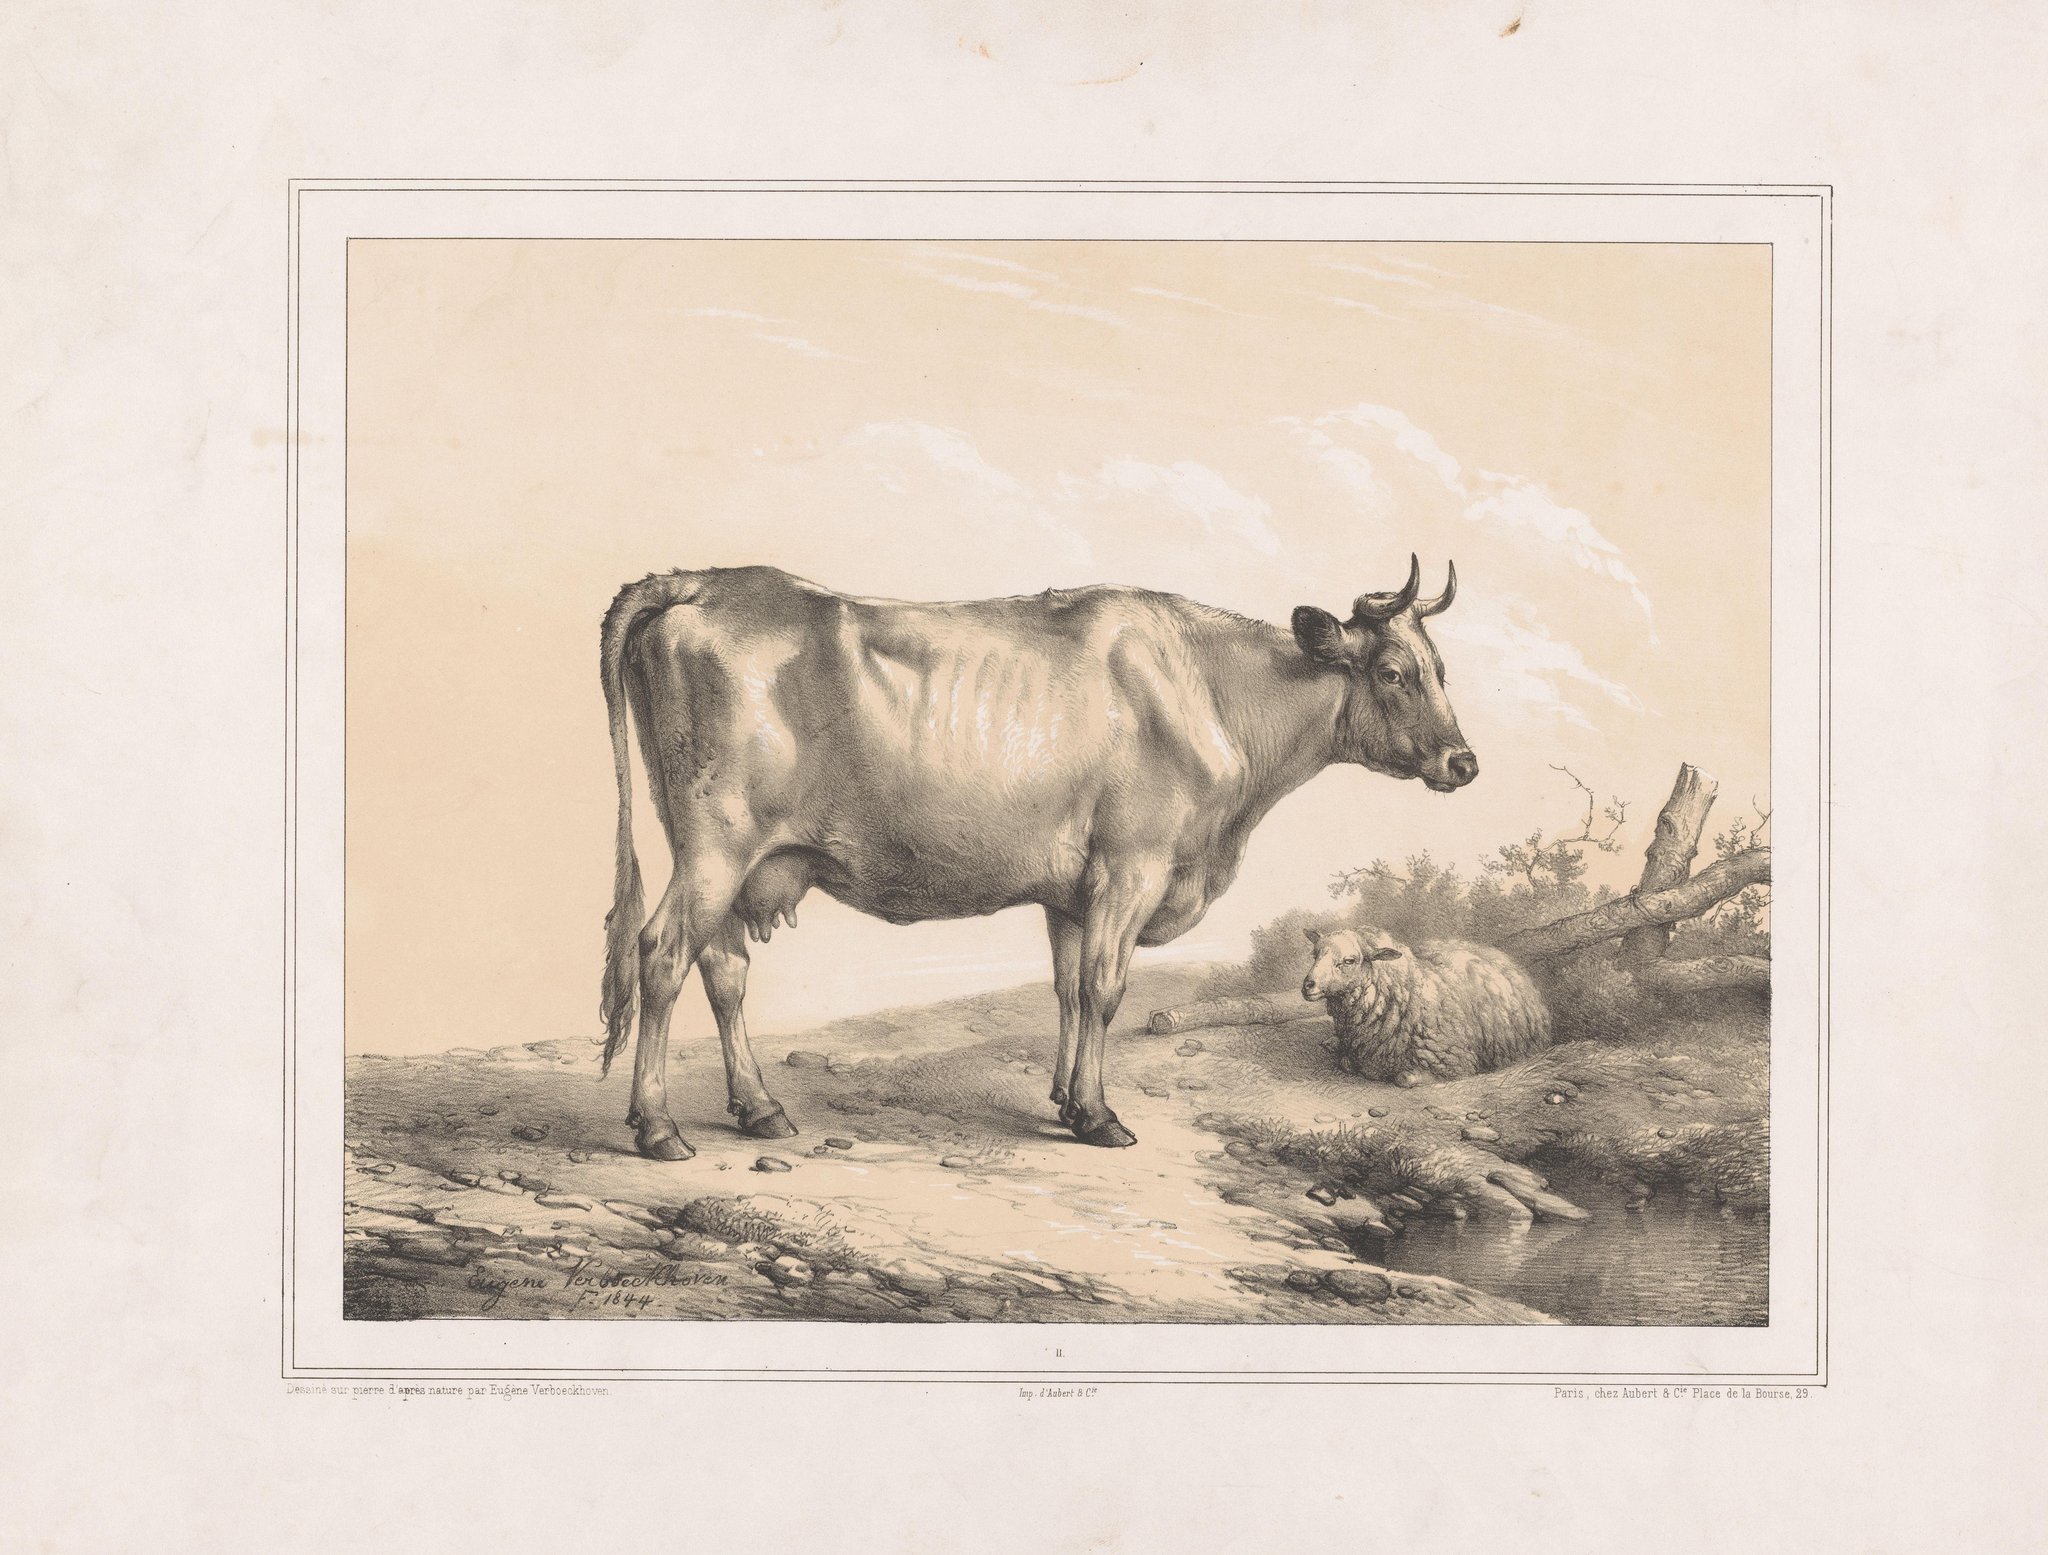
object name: print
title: Diverse tamme dieren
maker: eugène verboeckhoven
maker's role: draughtsman, painter, print maker, printer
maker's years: 1798-1881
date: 1844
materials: paper, pencil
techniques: tone lithography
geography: paris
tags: cow, sheep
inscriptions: collector's mark: Lugt 2228